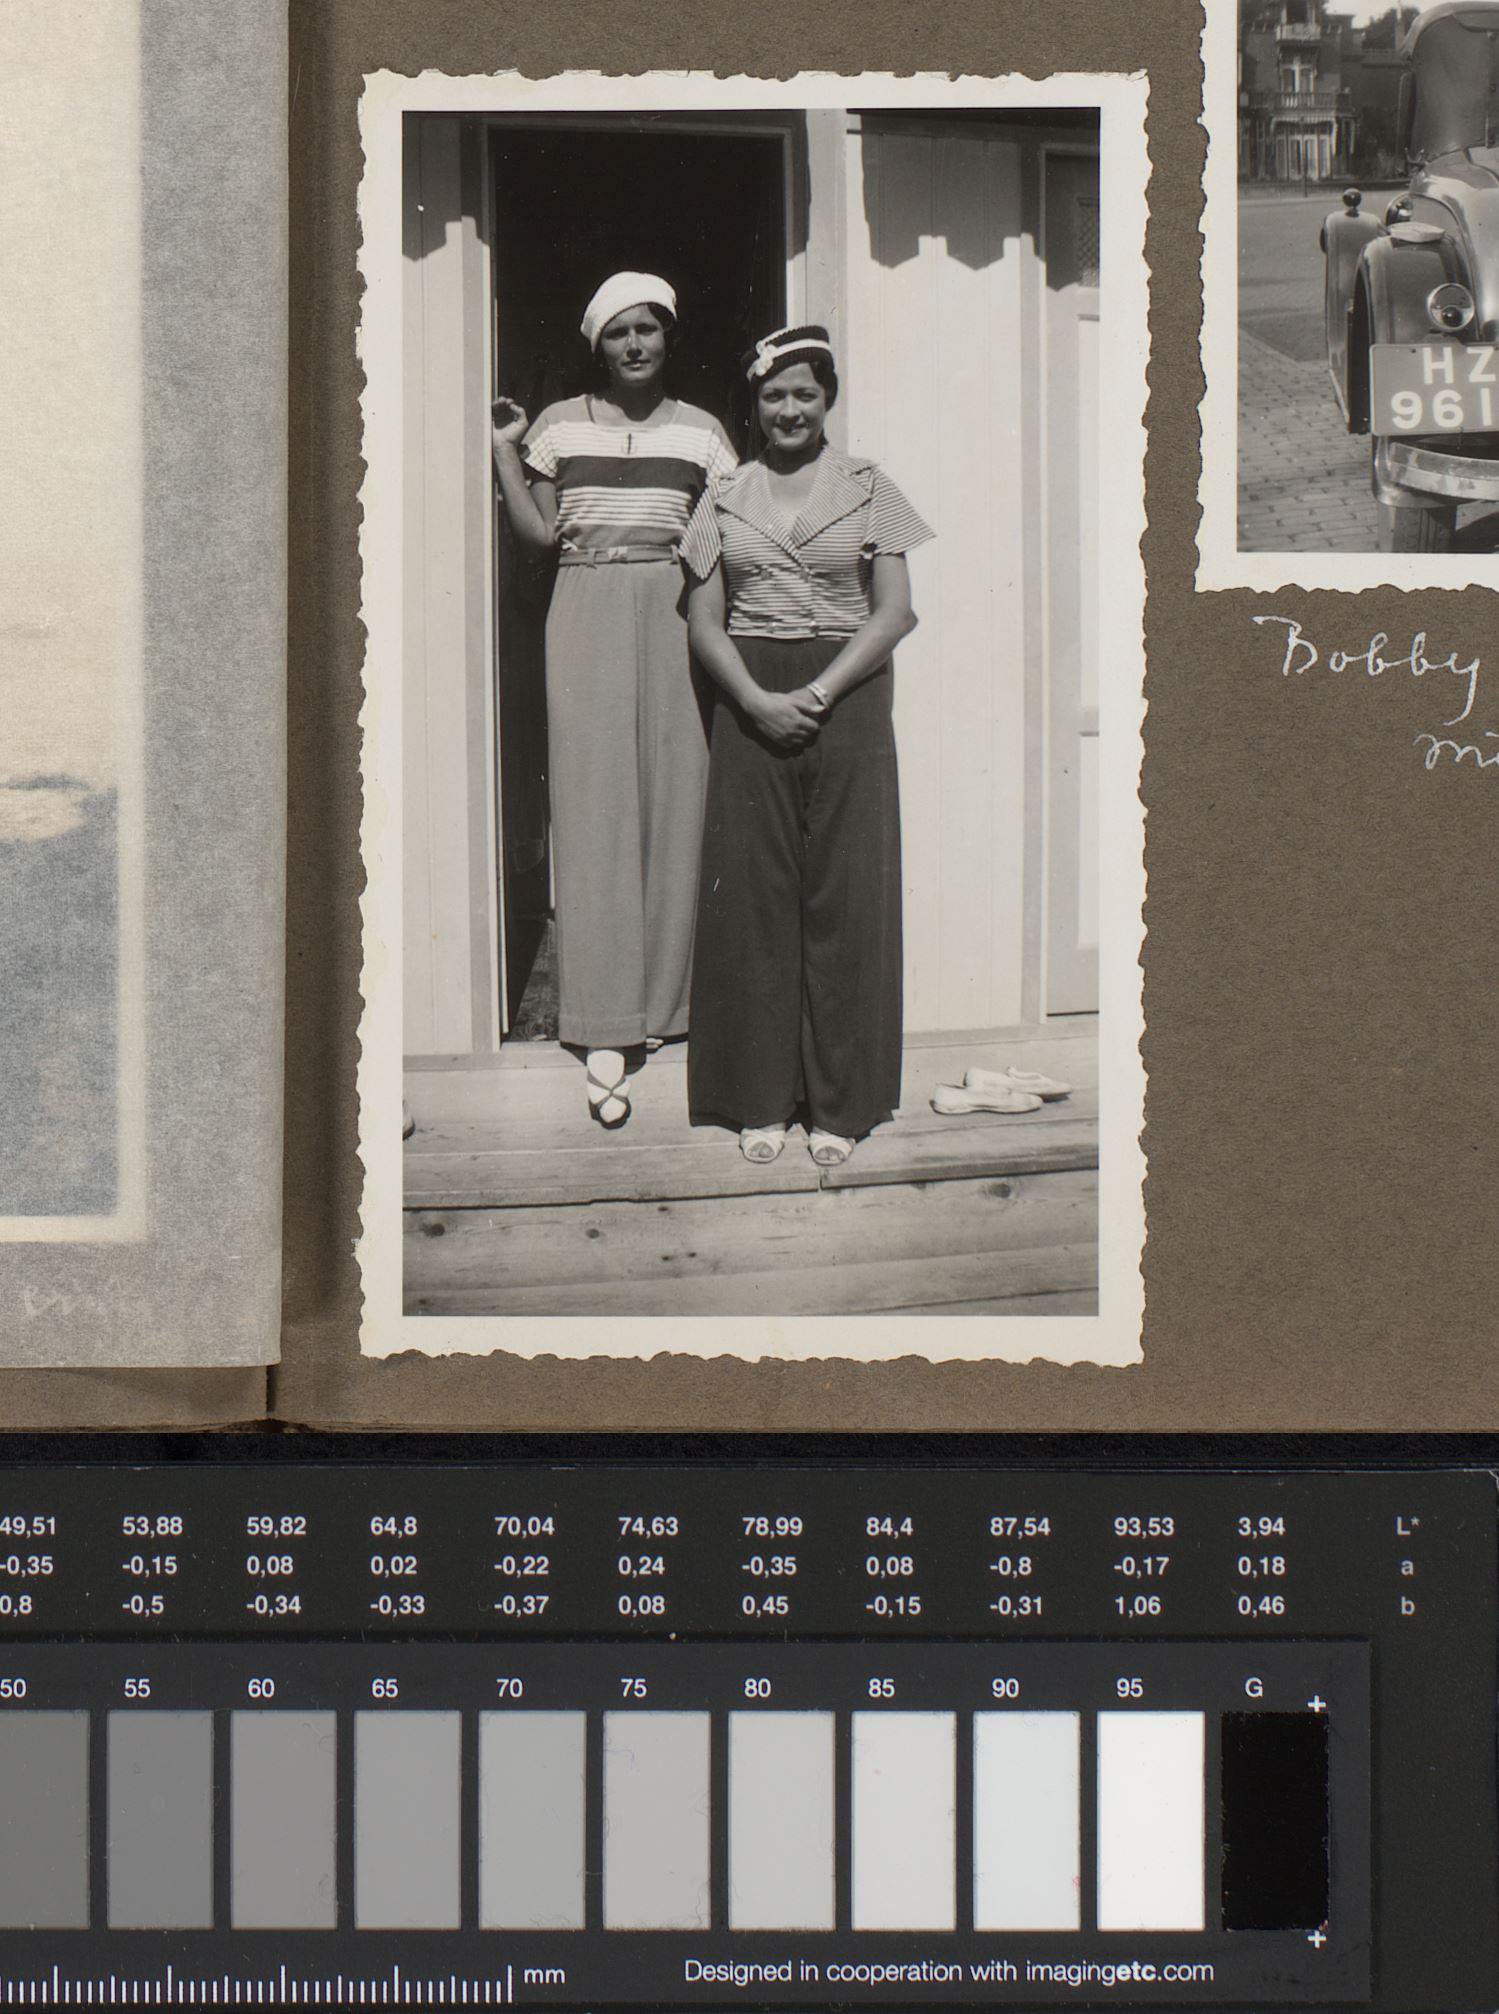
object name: photograph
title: Wilhelmina van Zijll de Jong en een andere vrouw in een deuropening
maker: Anonymous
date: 1933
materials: paper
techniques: gelatin silver print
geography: the hague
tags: wilhelmina van zijll de jong, historical persons - bb - woman